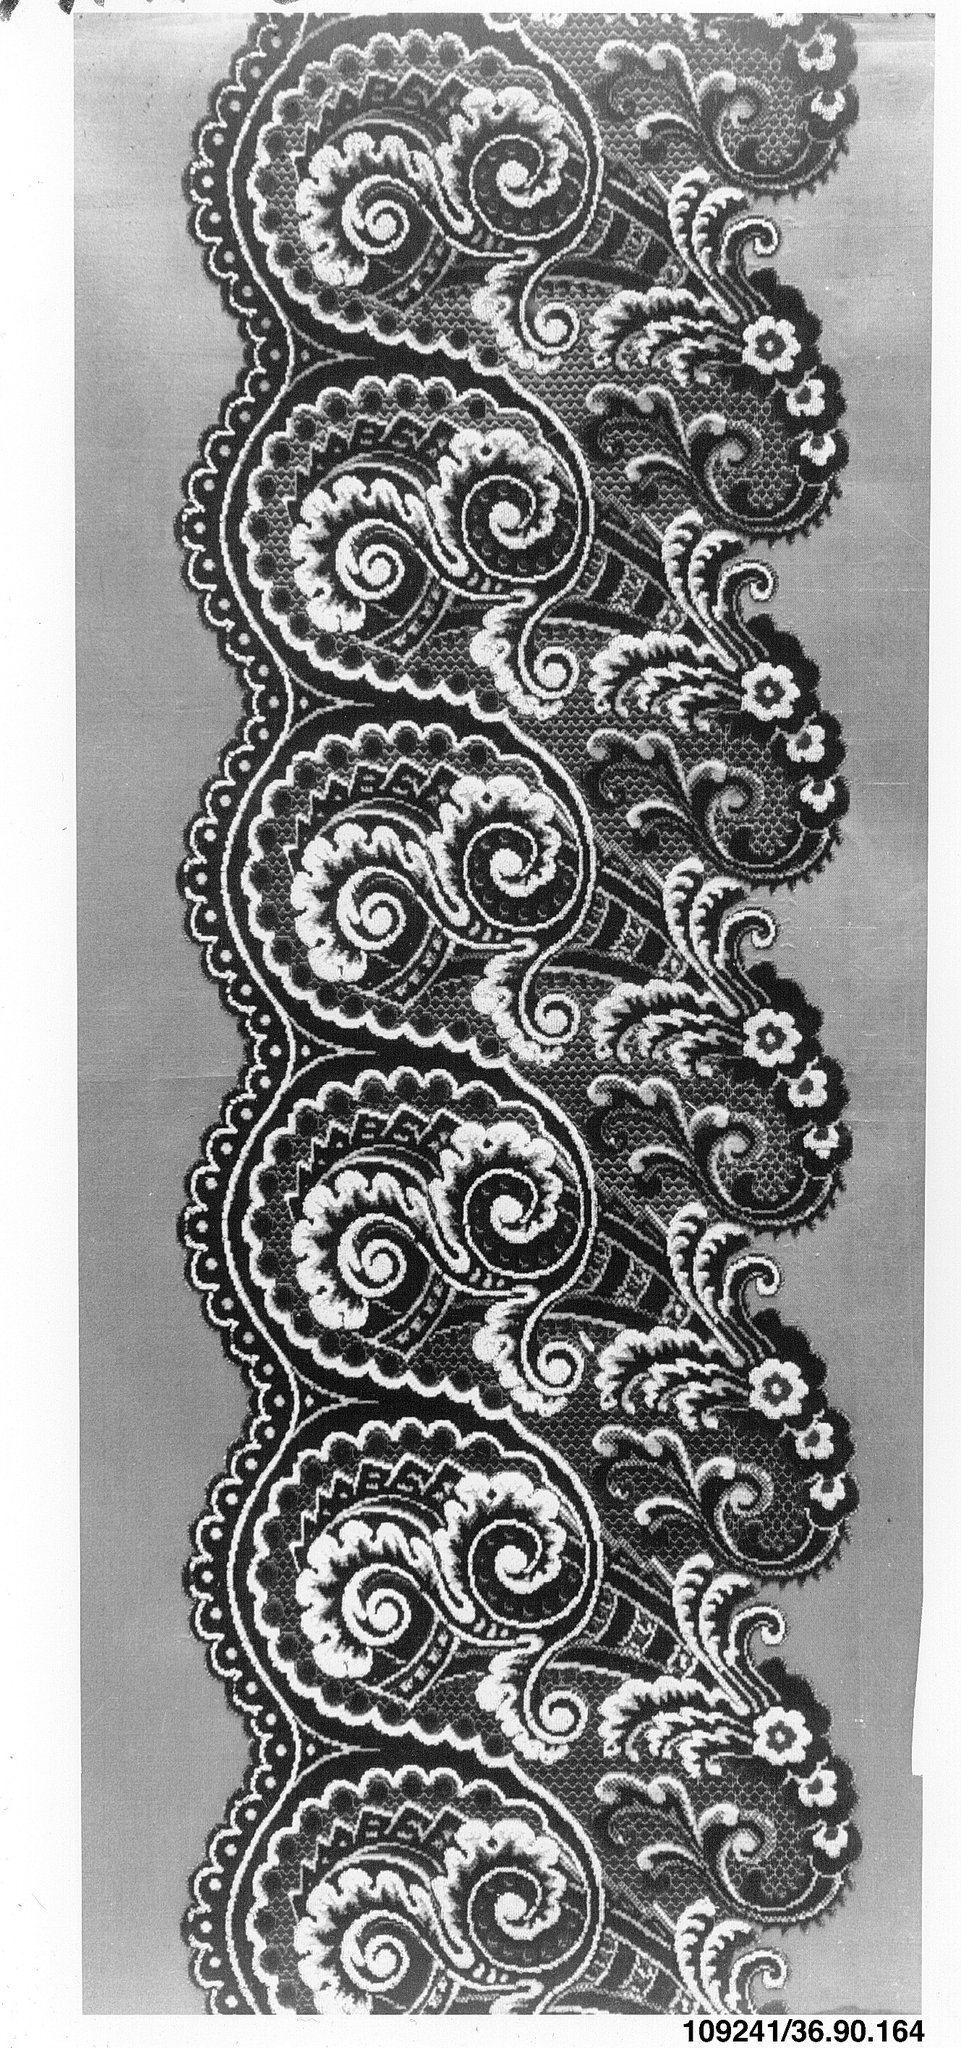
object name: border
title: Dress border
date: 1801-1900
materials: silk